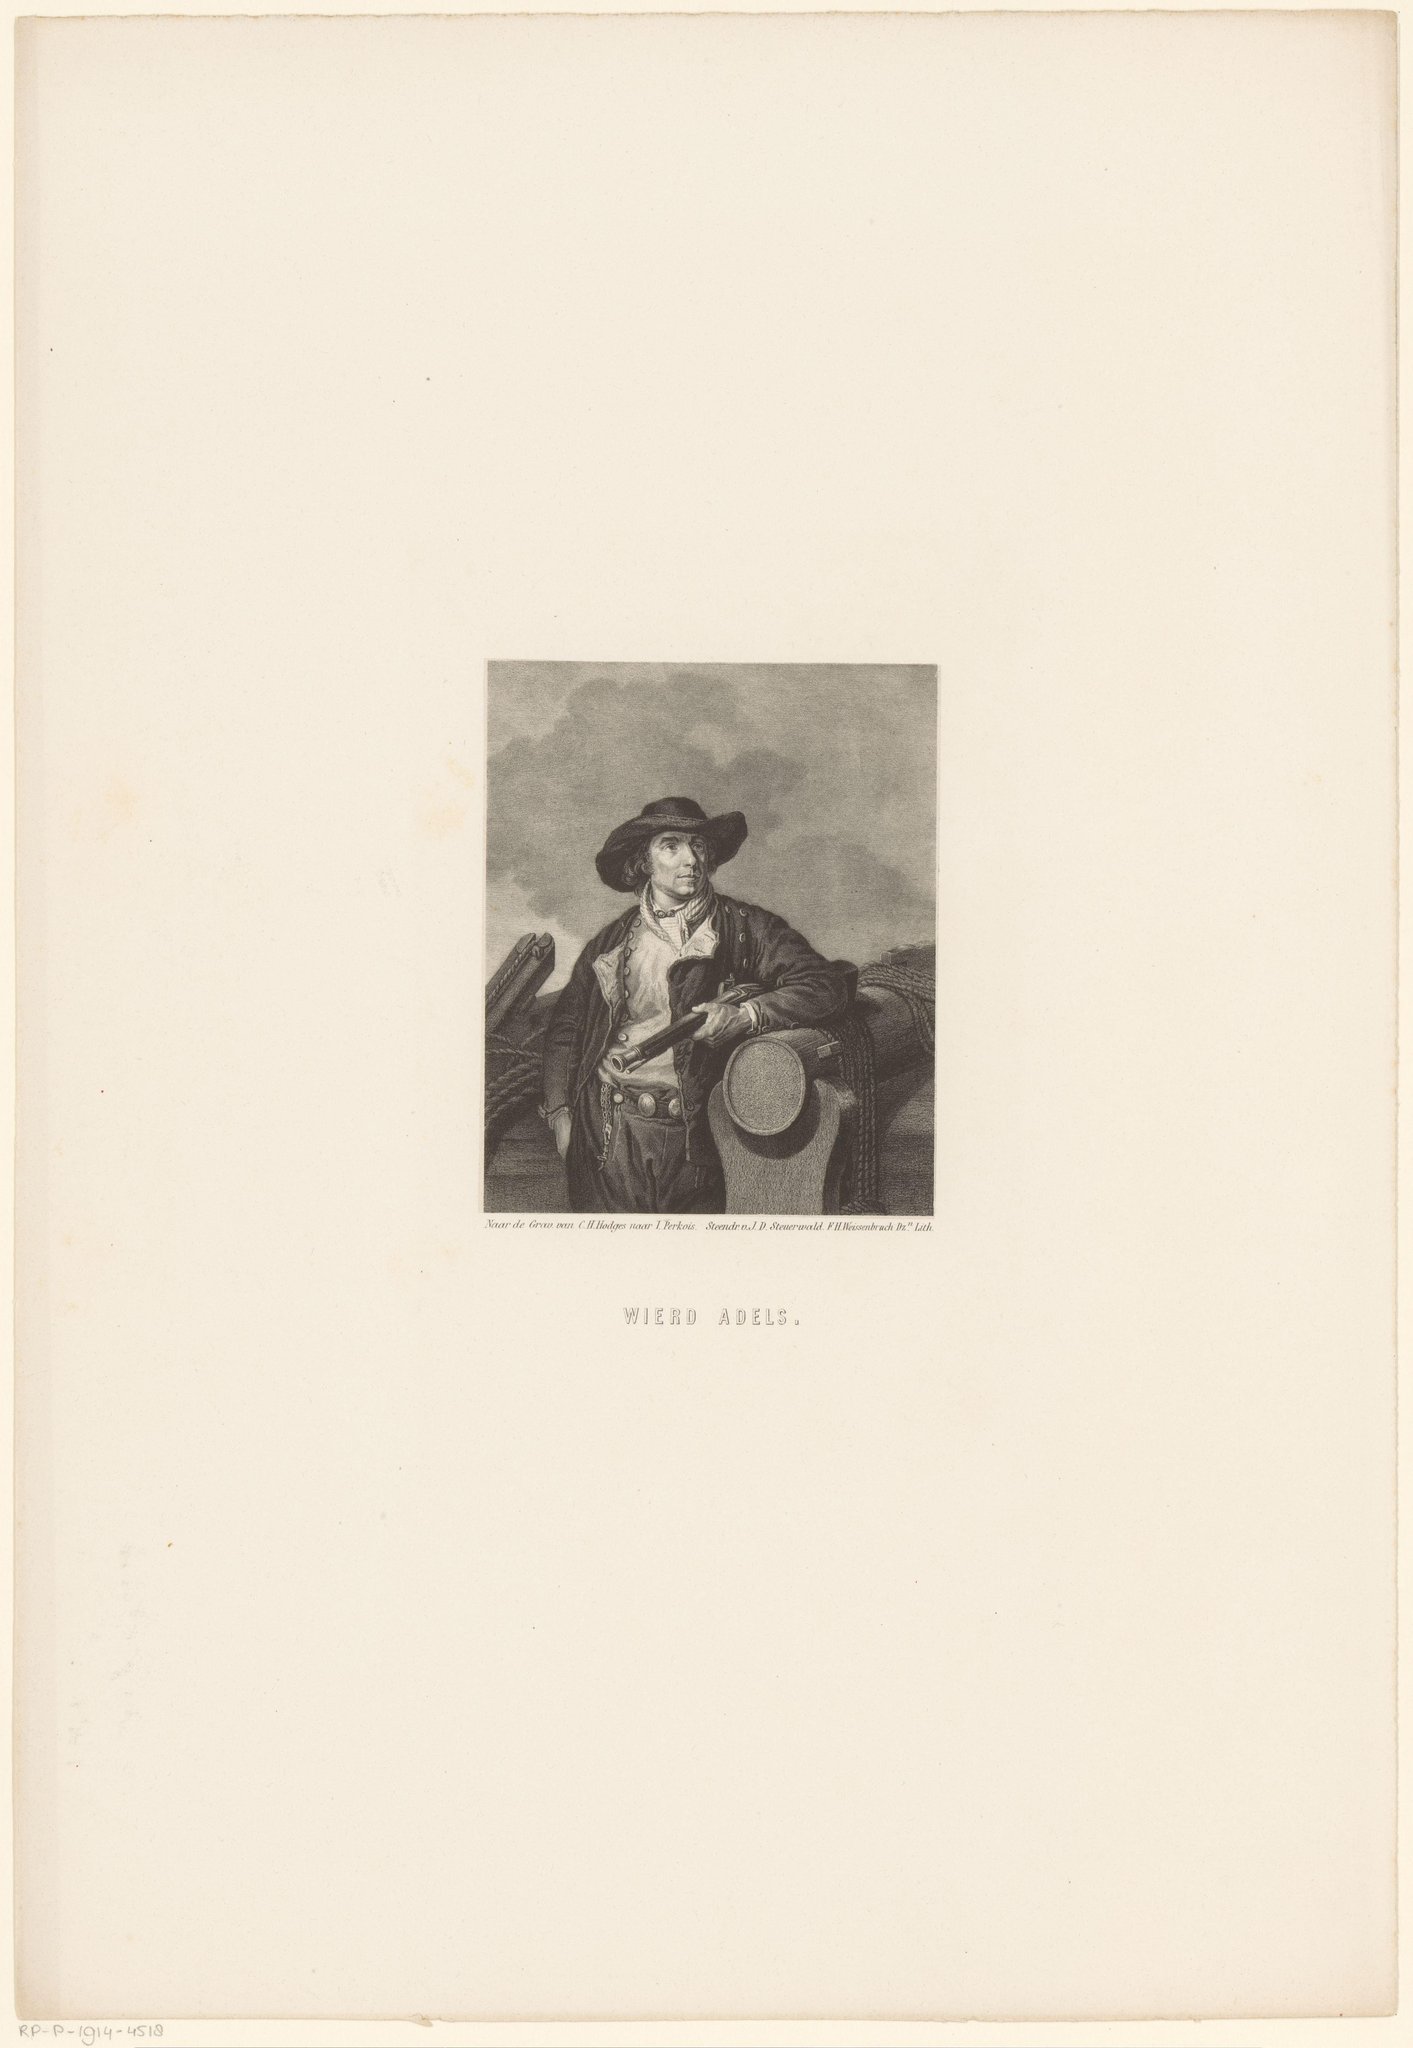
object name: print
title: Wierd Adels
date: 1858-1862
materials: paper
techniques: lithograph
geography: the hague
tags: historical persons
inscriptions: collector's mark: Lugt 2228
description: Prent uit: Jonge, J.C. de. Geschiedenis van het Nederlandsche zeewezen. Haarlem: Jonge, J.K.J. de, 1858-62.